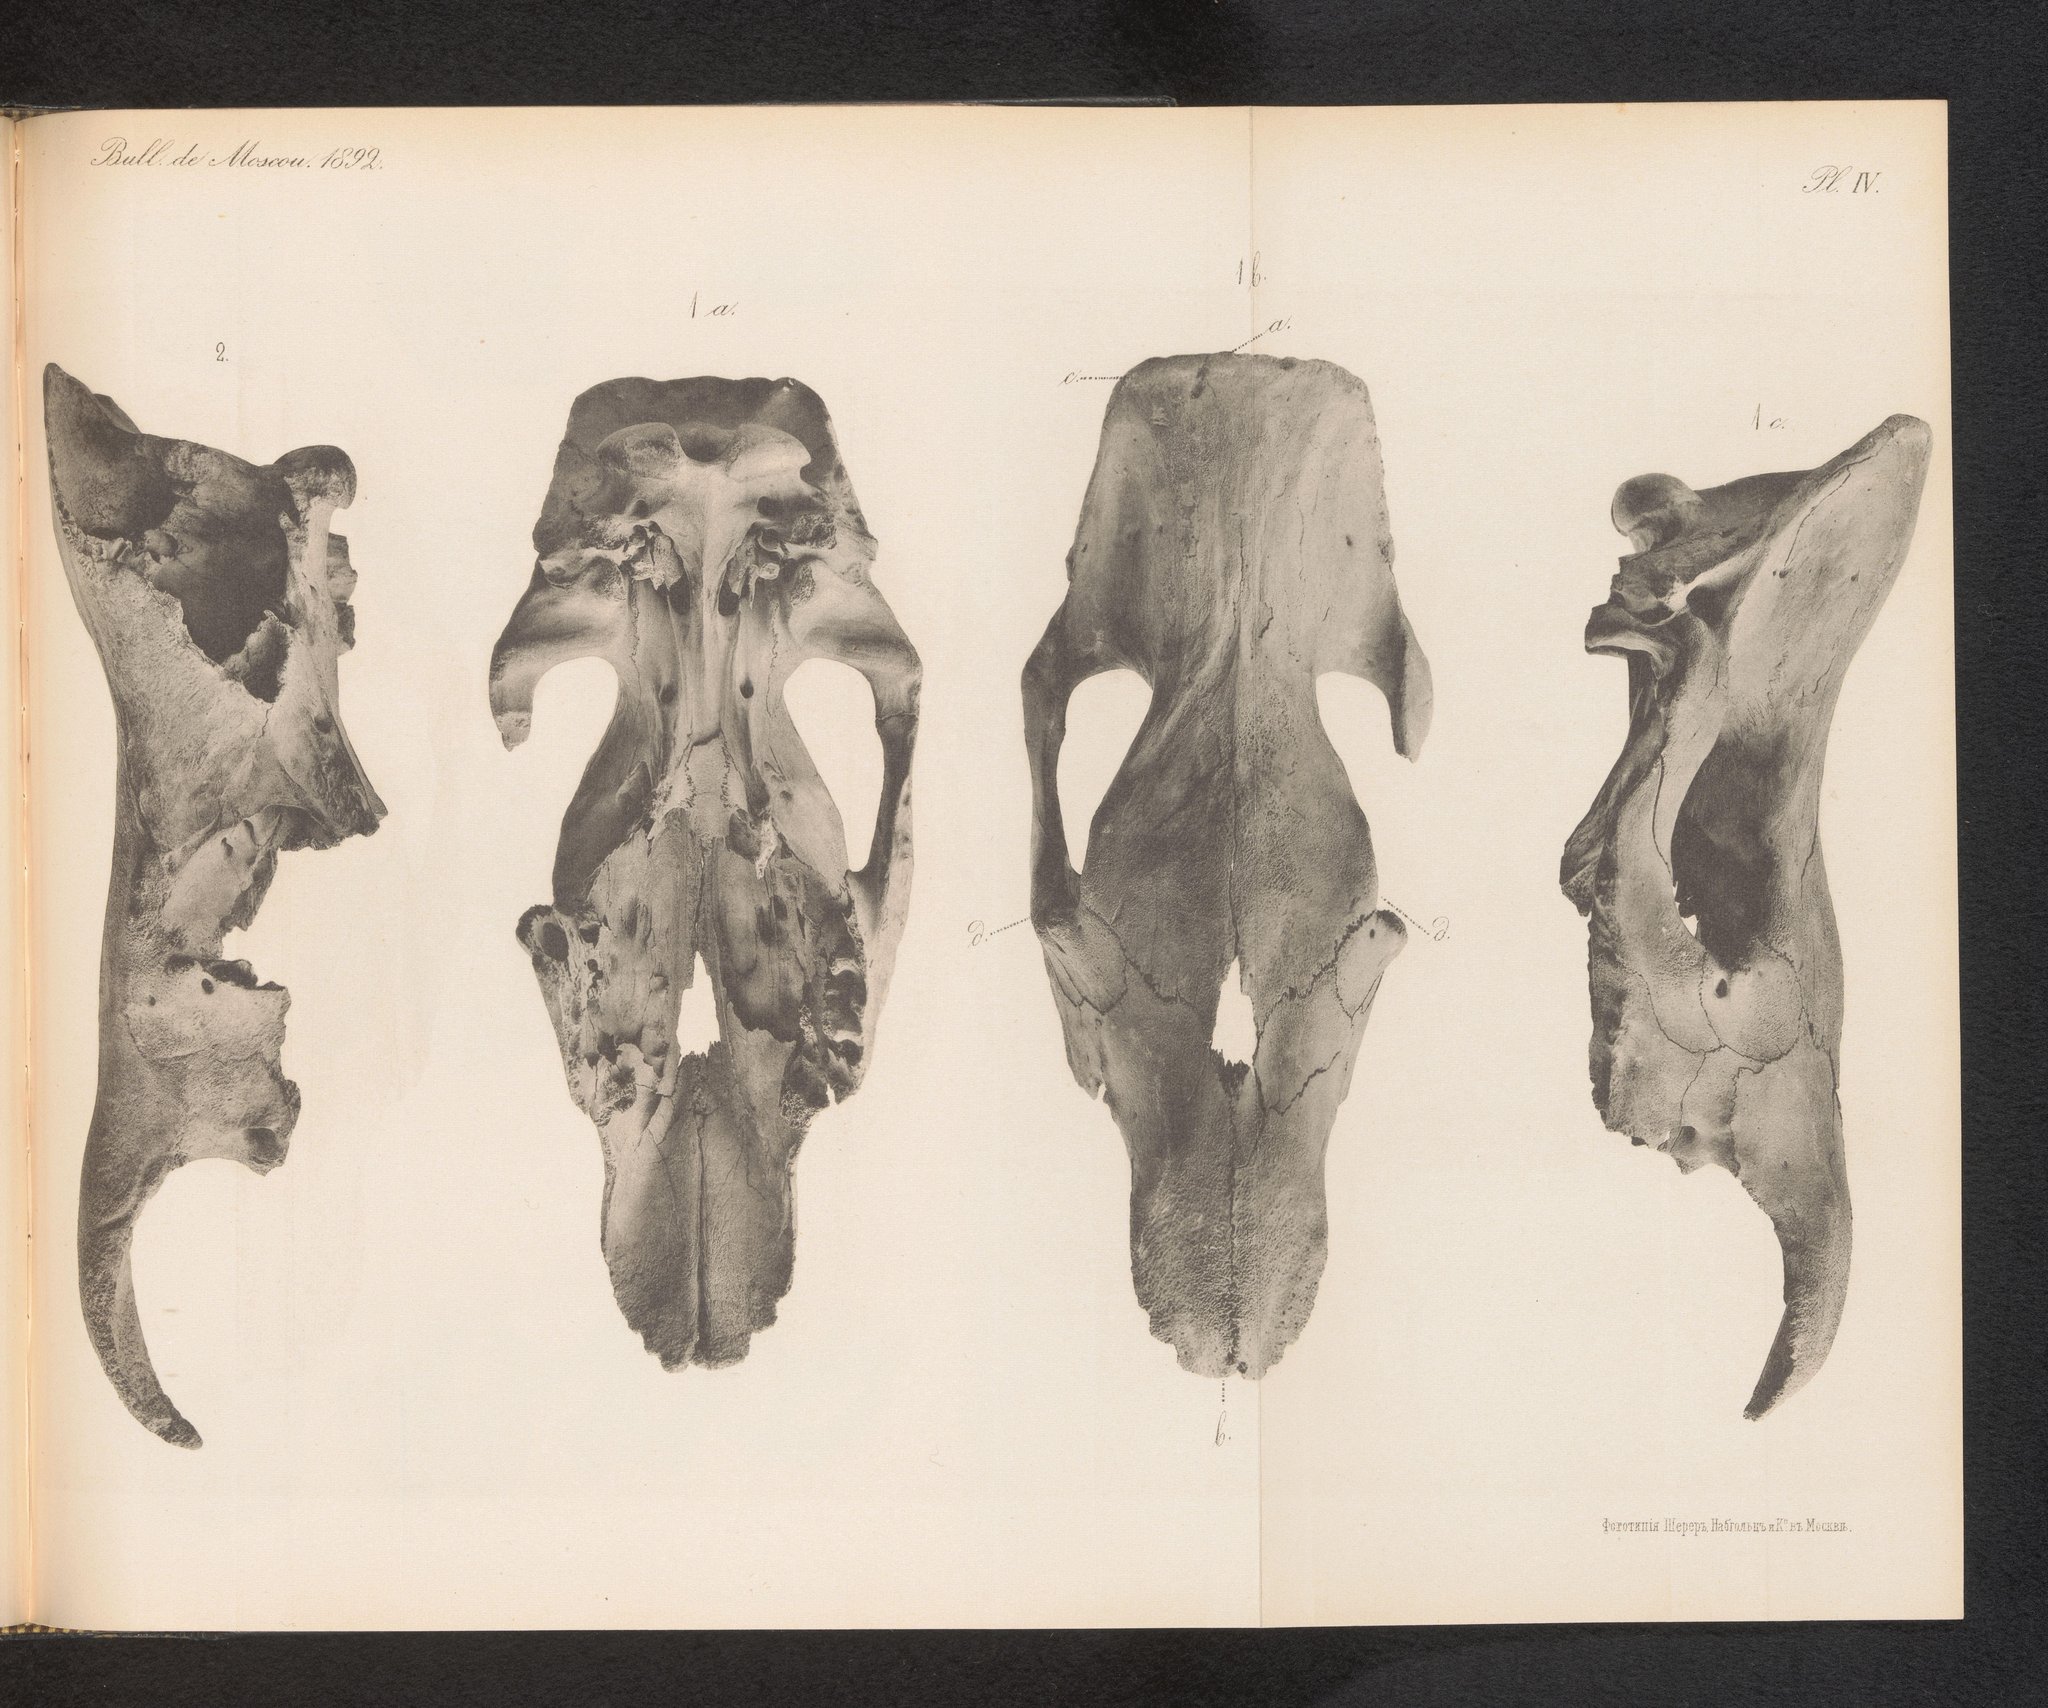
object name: page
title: Vier aangezichten van eens schedel van een wolharige neushoorn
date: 1888-1893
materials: paper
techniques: photoaquatint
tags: animals (+ skeleton of an animal), hoofed animals: rhinoceros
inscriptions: number: ‘PL IV./ 2/ 1a/ 1b/ 1c’